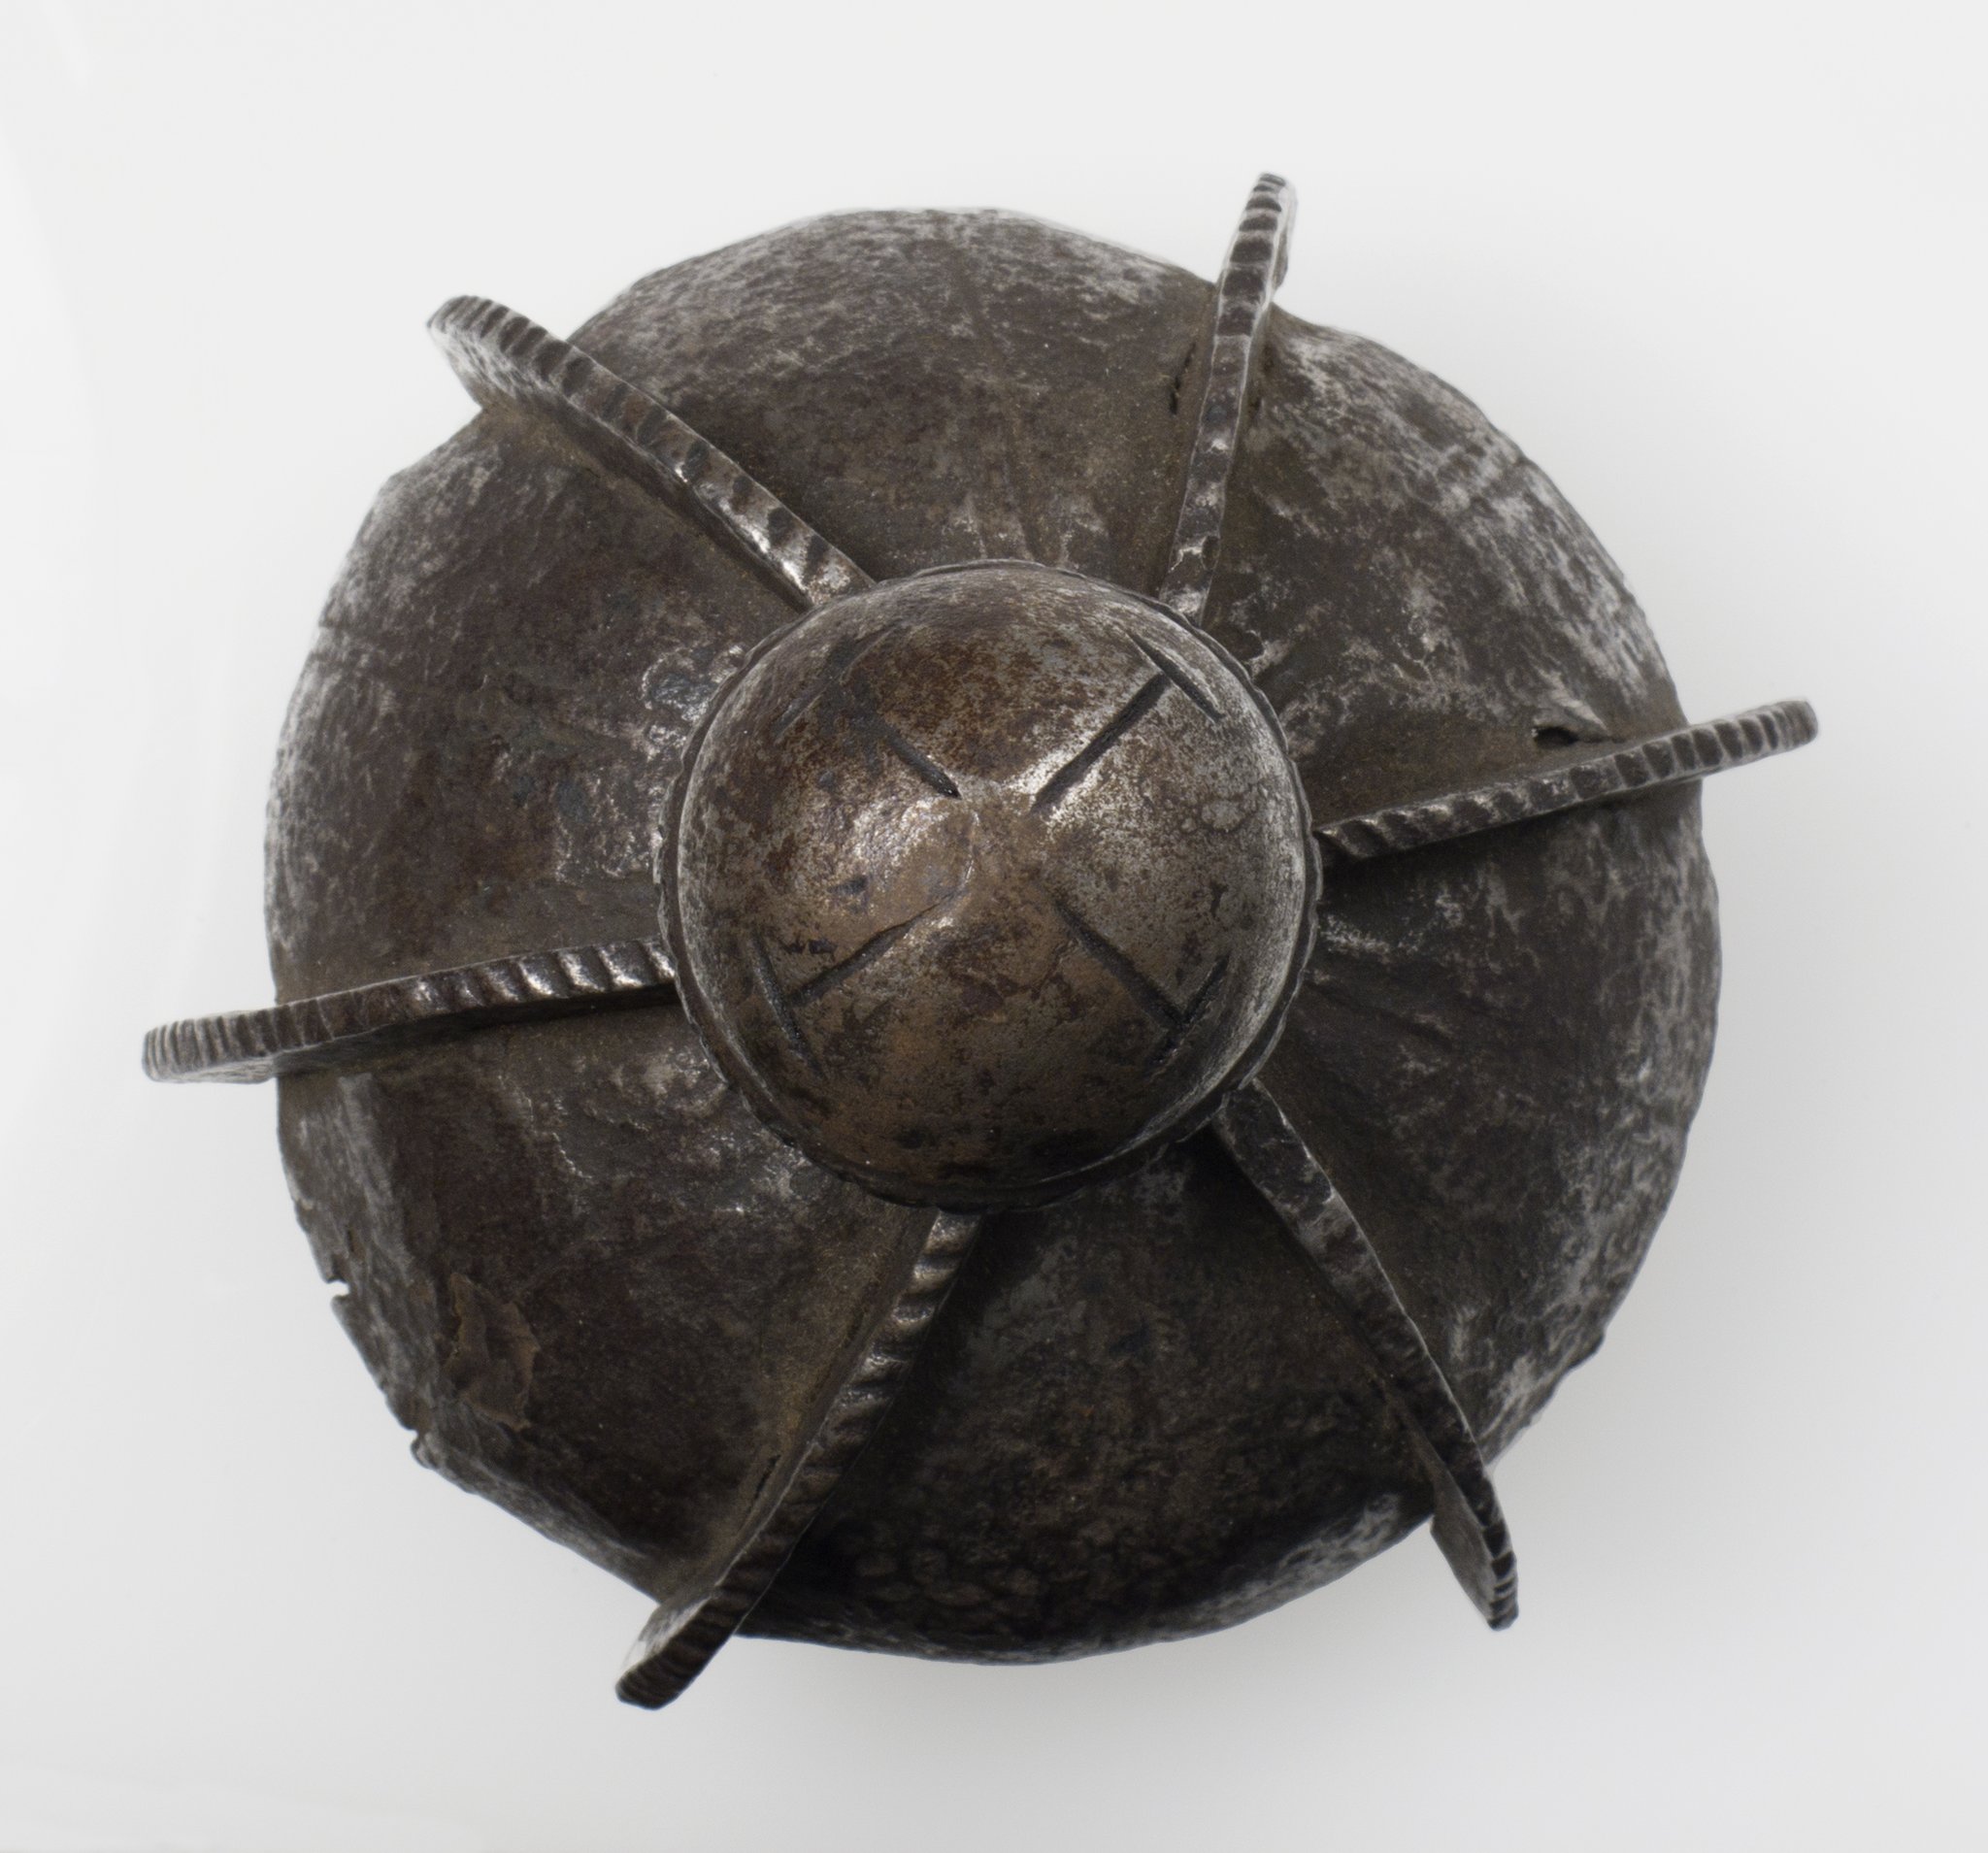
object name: bos and nail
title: Boss and Nail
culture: european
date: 1401-1600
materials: iron